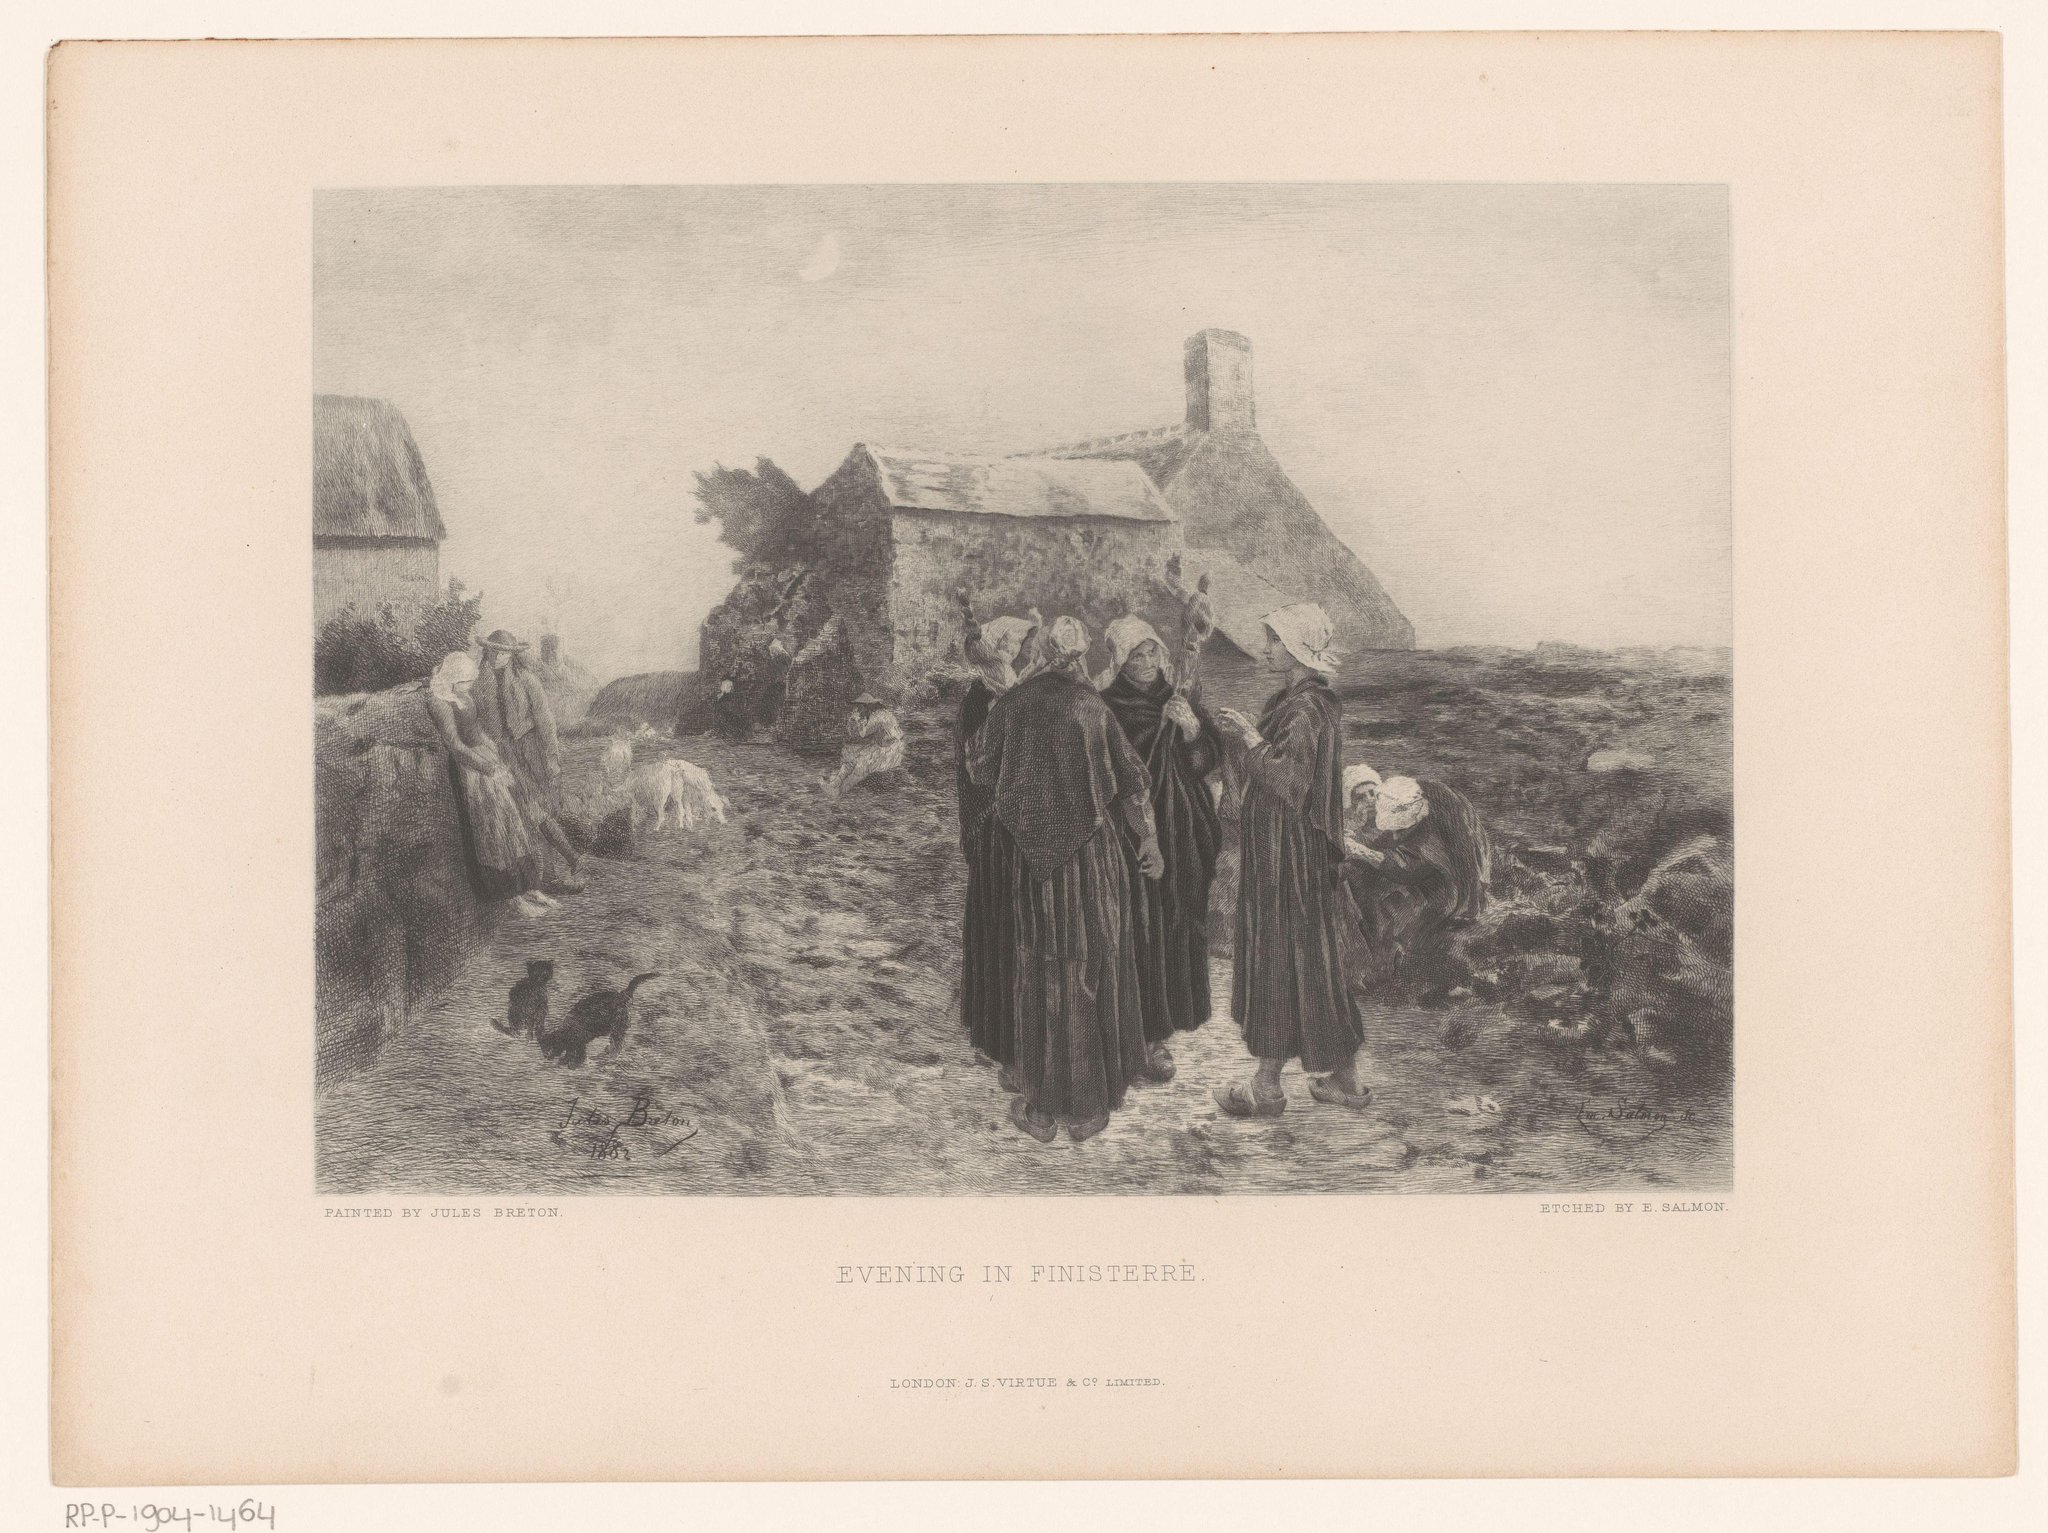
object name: print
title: Evening in Finisterre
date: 1850-1904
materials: paper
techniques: etching, intaglio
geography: london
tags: farmers - aa - female farmer, farmer's wife, spindle, rural life, country-house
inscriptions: collector's mark: Lugt 2228